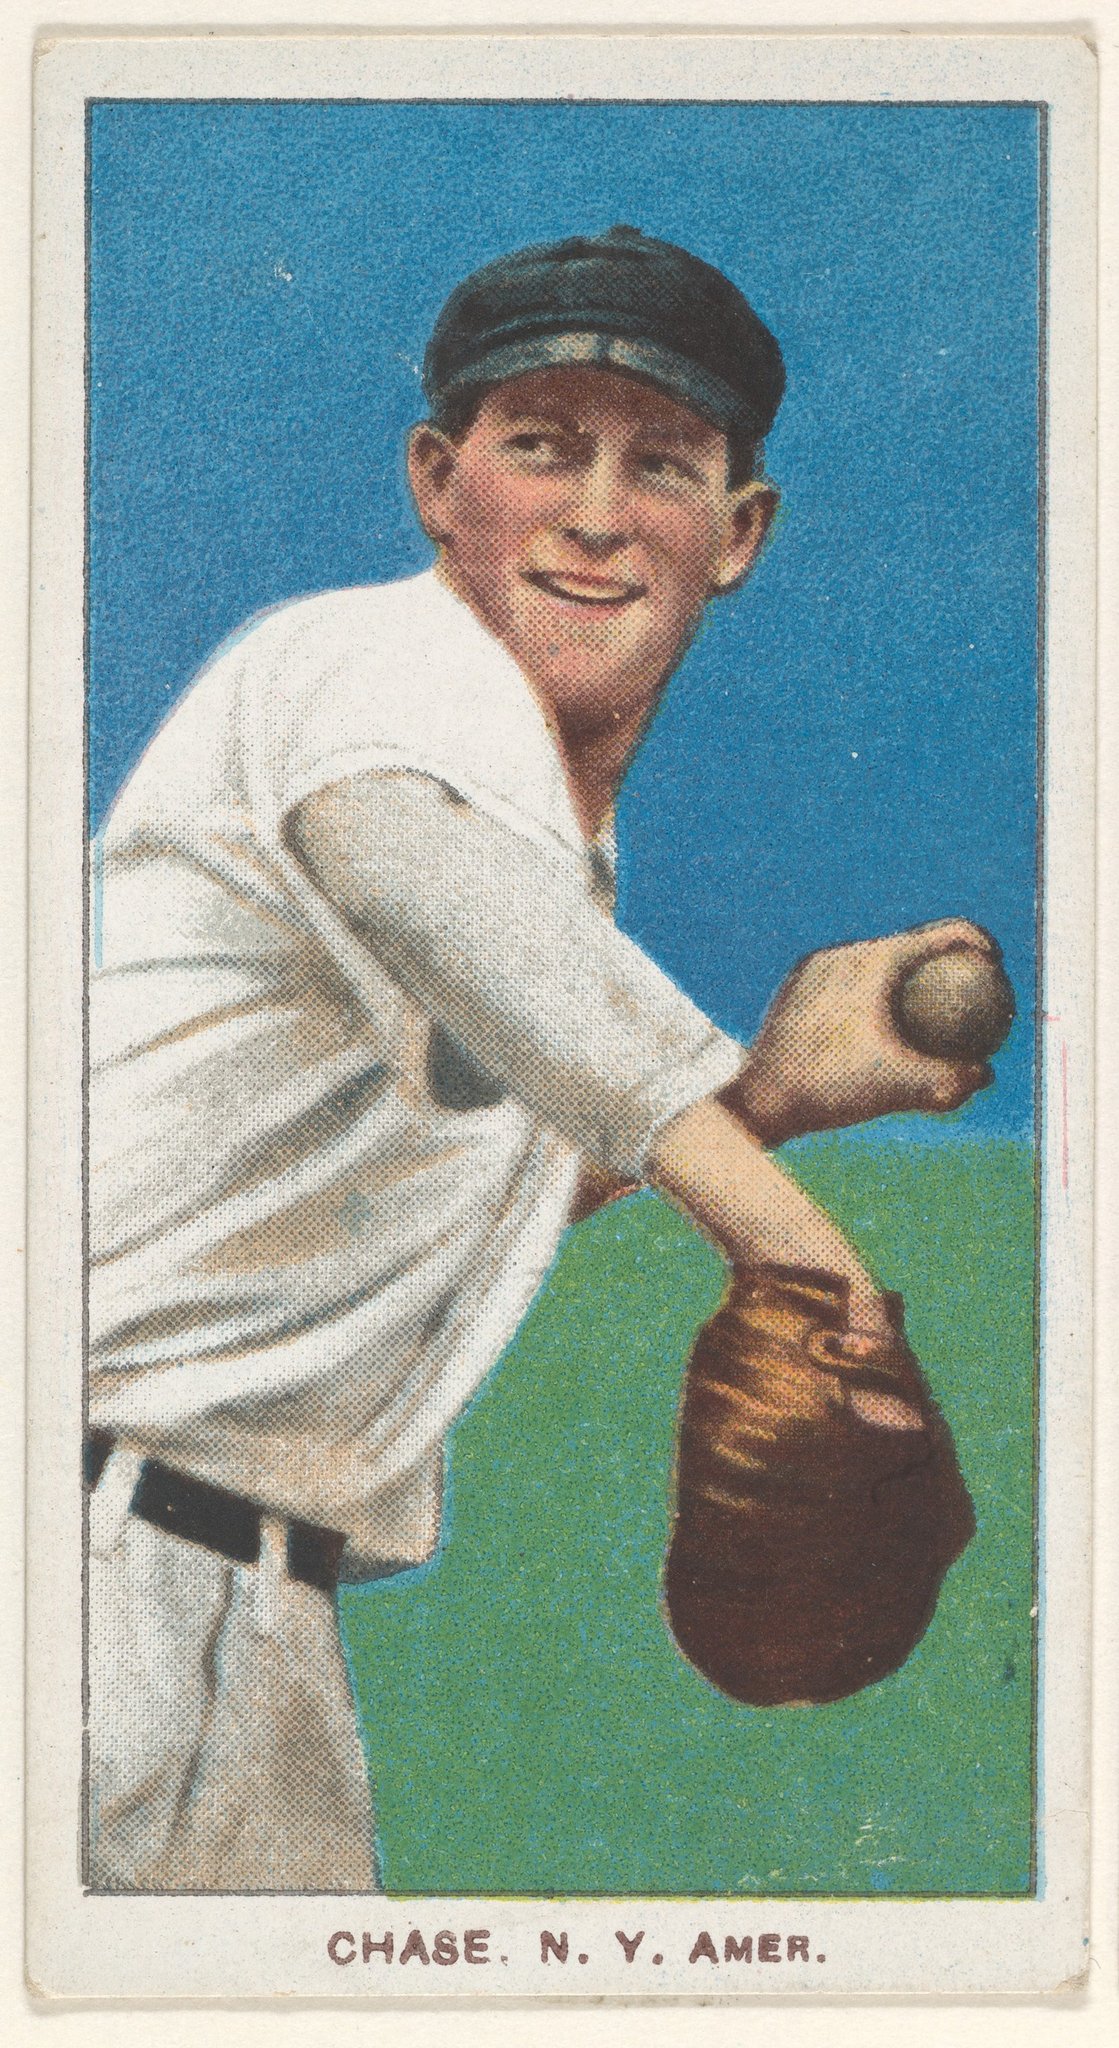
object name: baseball card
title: Chase, New York, American League, from the White Border series (T206) for the American Tobacco Company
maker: american tobacco company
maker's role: publisher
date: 1909-1911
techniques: lithography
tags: men,baseball,athletes